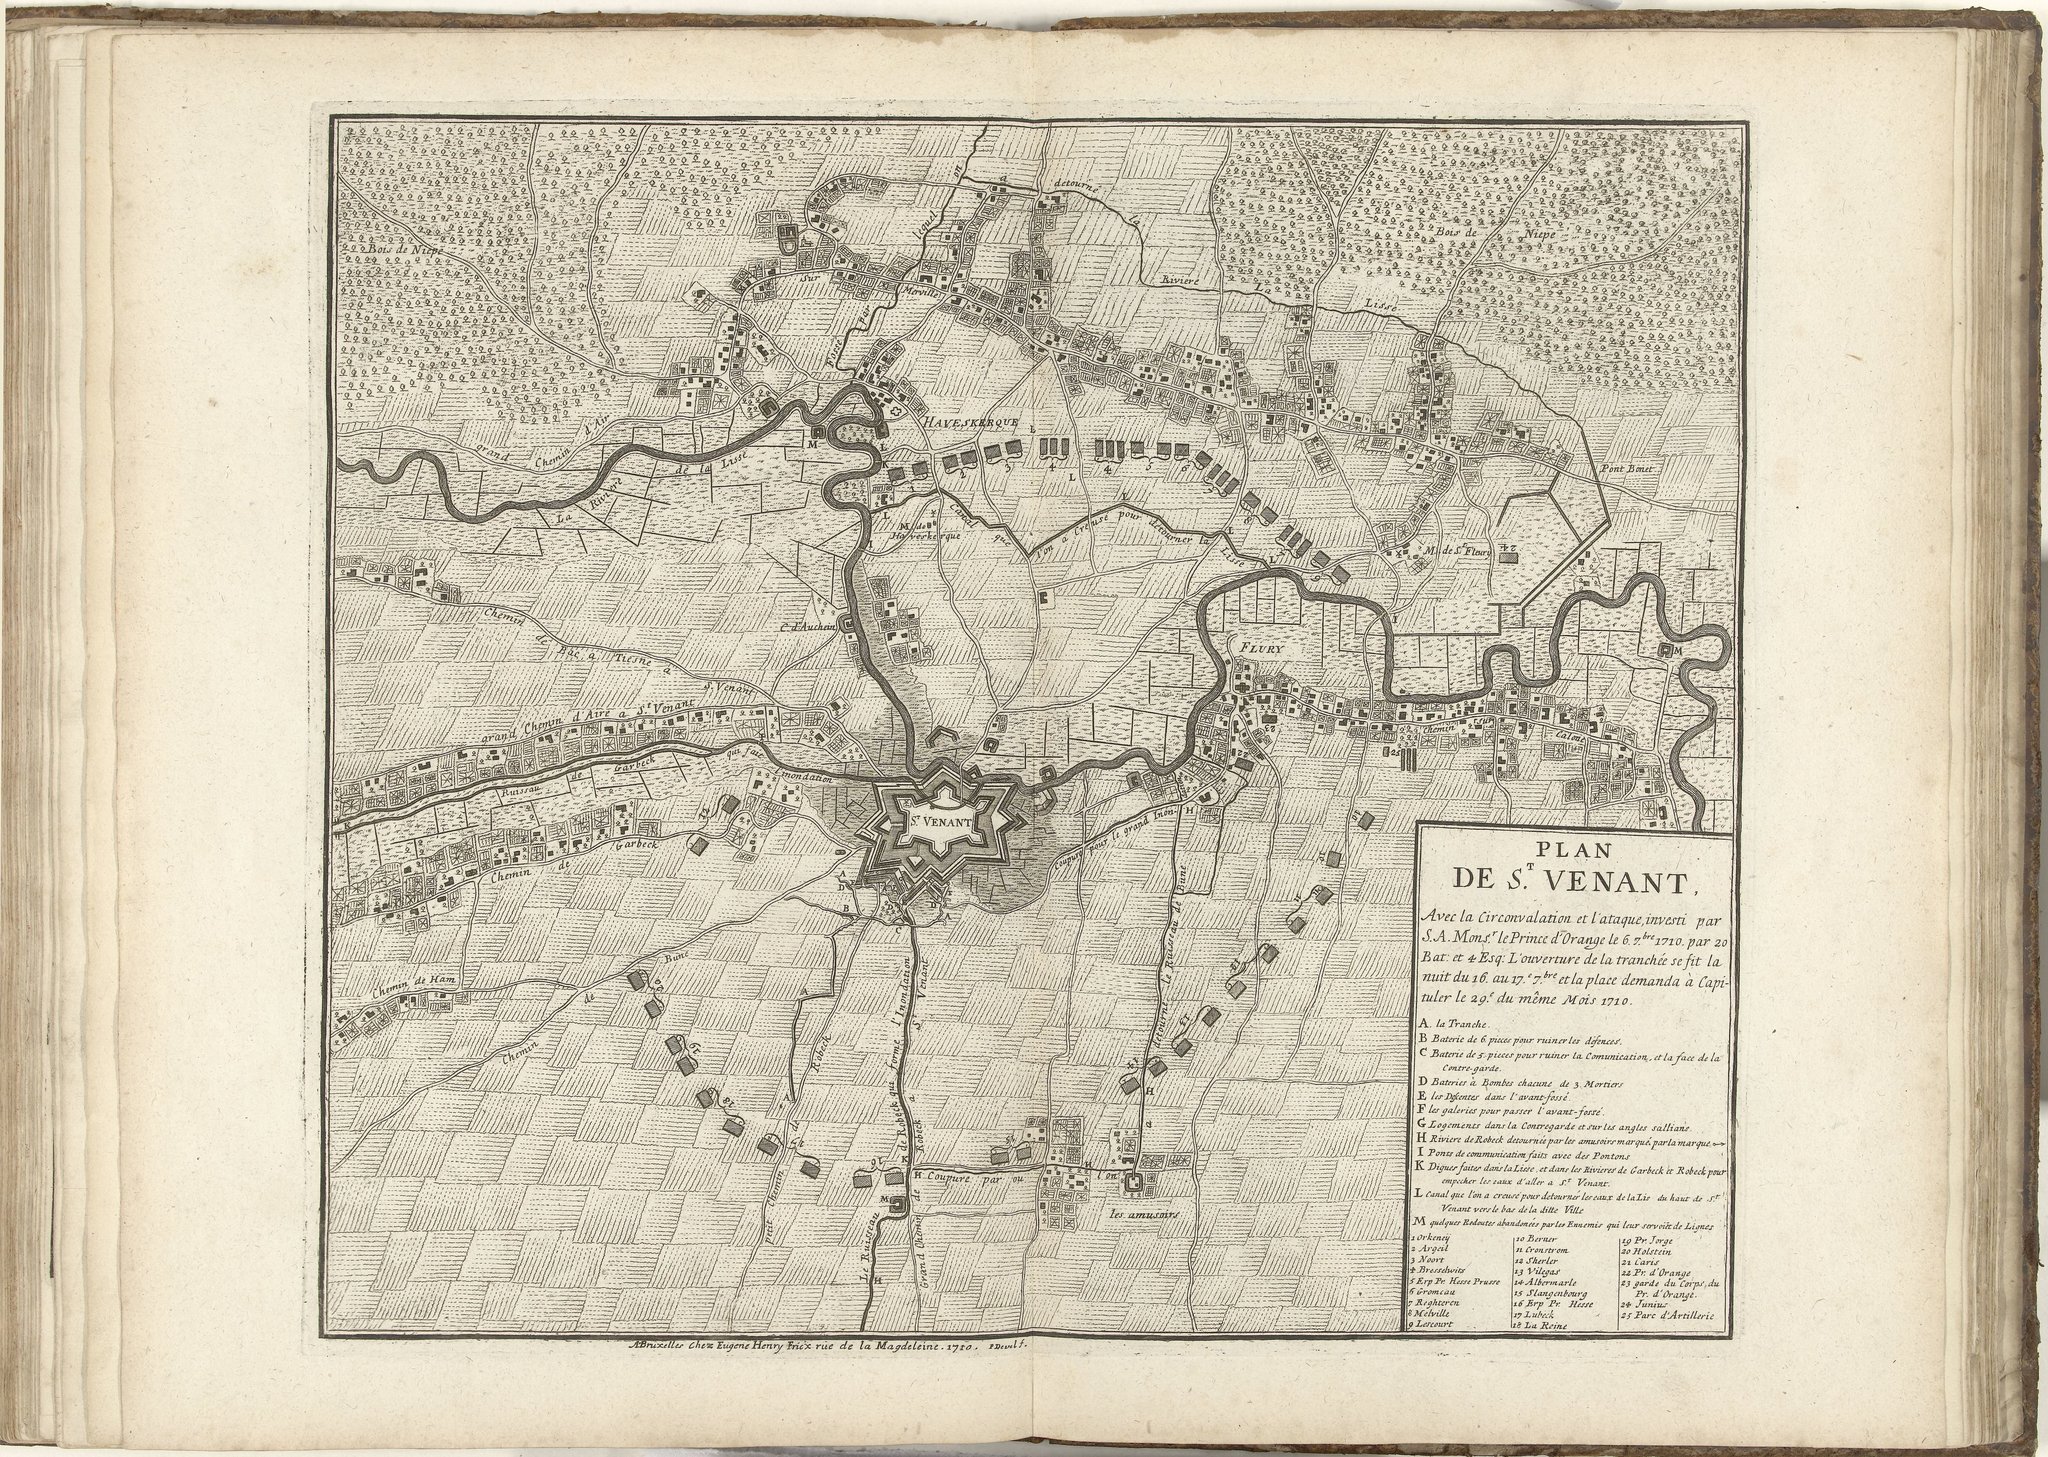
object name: map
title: Beleg van Saint-Venant, 1710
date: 1710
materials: paper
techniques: etching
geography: brussels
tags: johan willem friso (prins van oranje-nassau), maps of separate countries or regions, siege, position war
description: Plattegrond van de stad Béthune met de aanvallen op de stad door de Geallieerden onder generaal Fagel op 23-24 juli en onder generaal Schoulenberg op 27 juli 1710. Onderaan is een strook aangeplakt (gedrukt van een aparte plaat) met de cartouche met de legenda A-E. Aan de rechterzijde van de prent is ook een strook aangeplakt (gedrukt van een aparte plaat) met de cartouche met de legenda a-e en een deel van het land. Onderdeel van een gebundelde verzameling van plannen van veldslagen en steden vermaard in de Spaanse Successieoorlog.